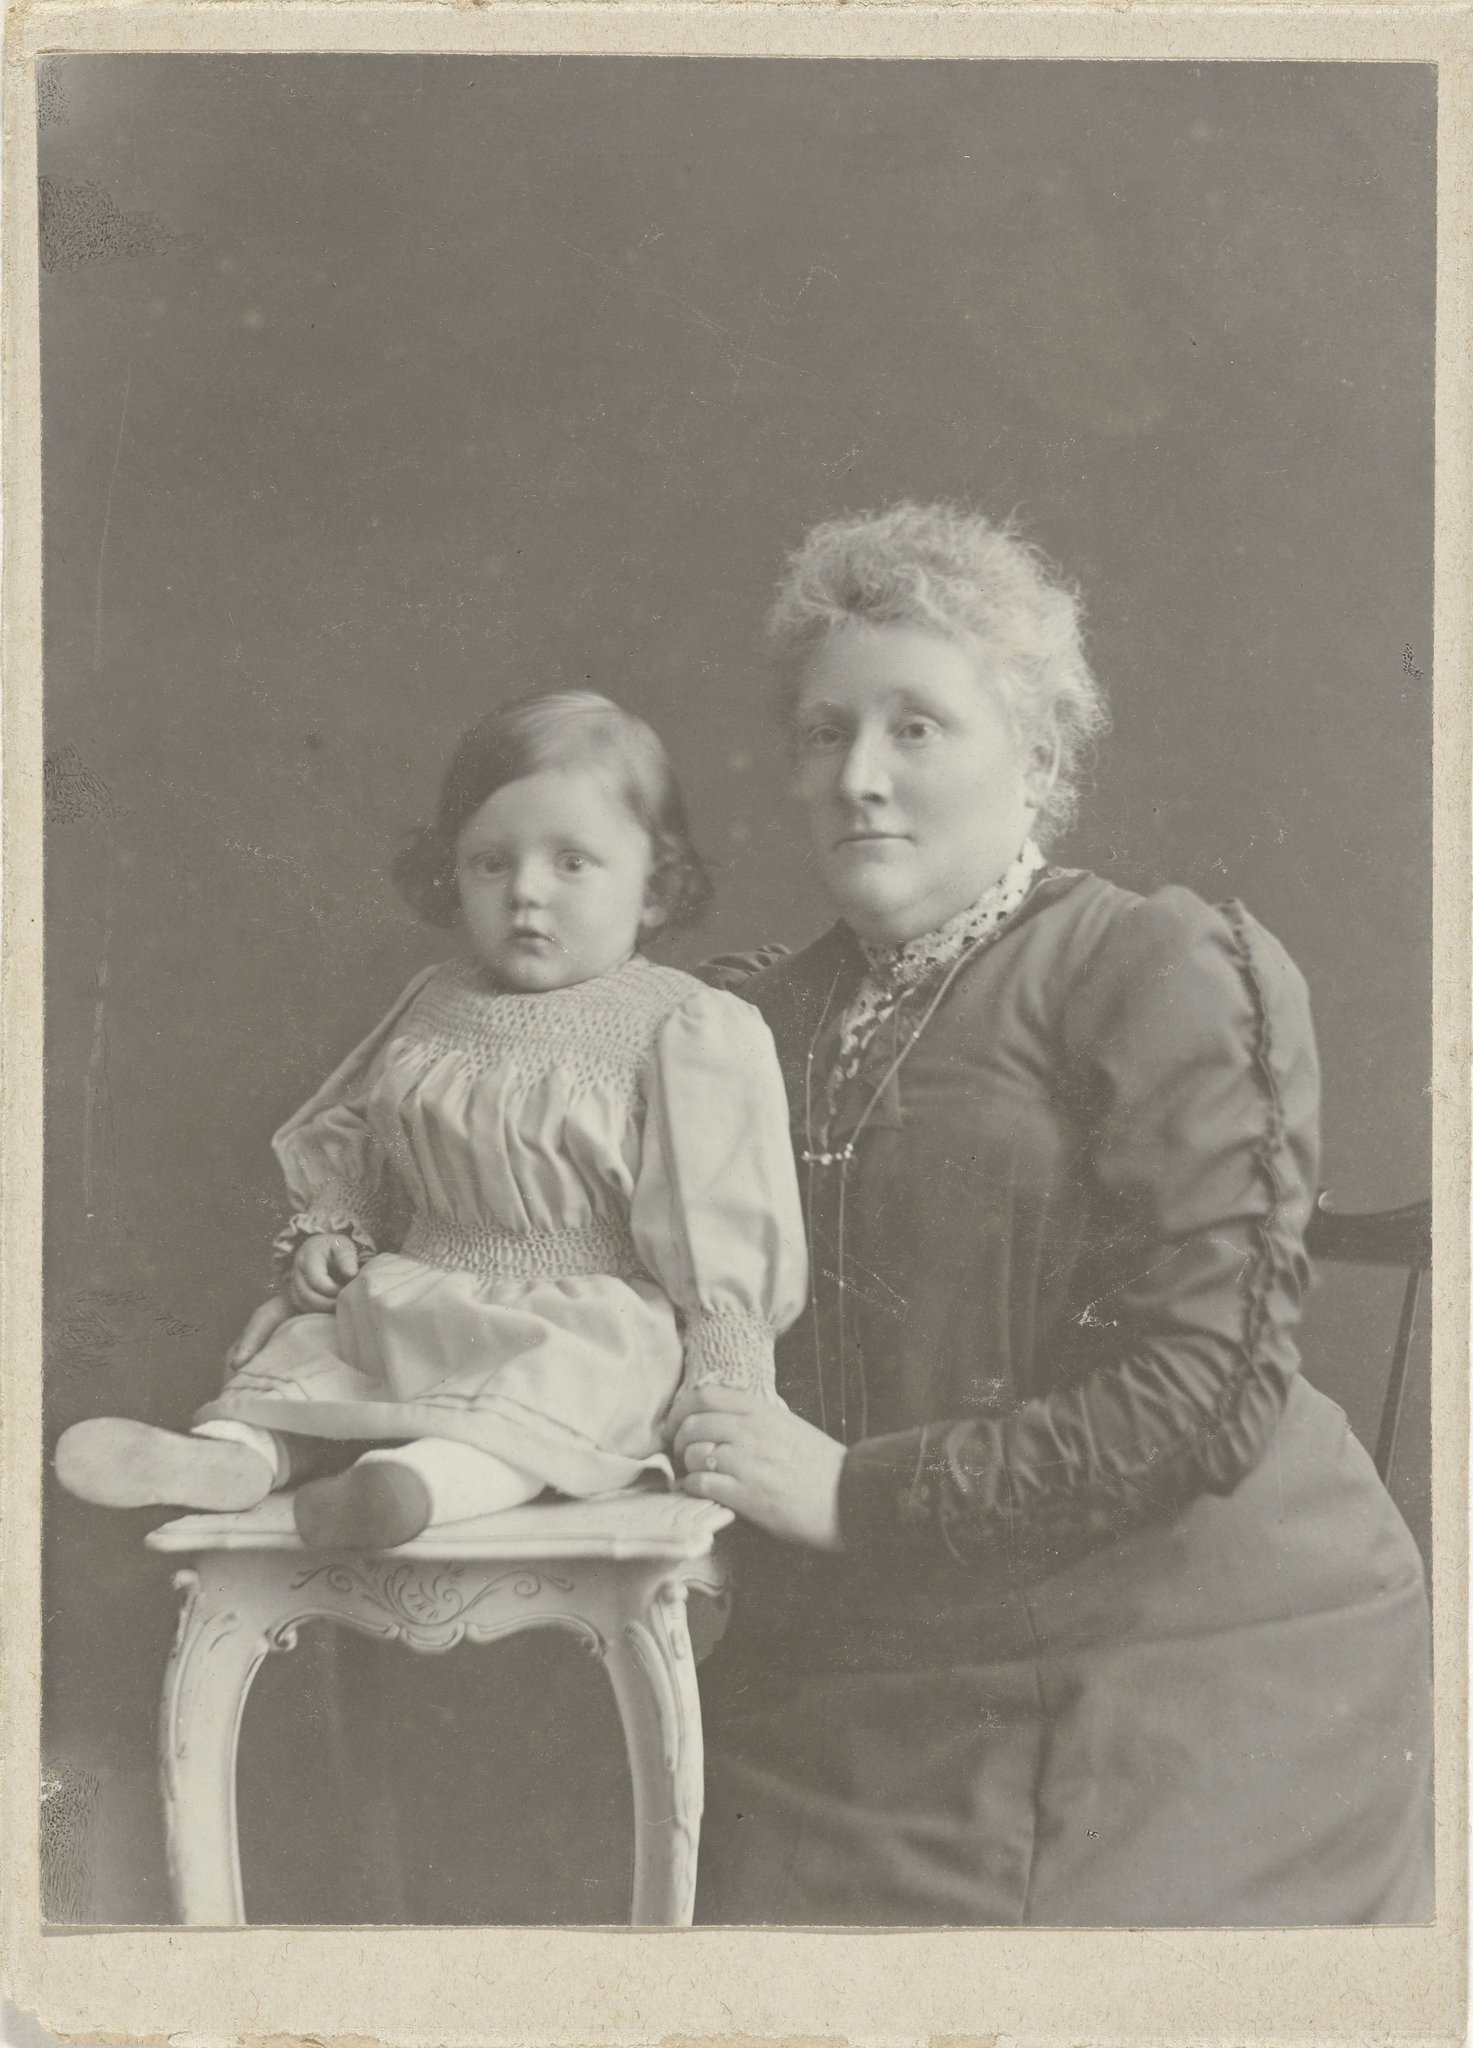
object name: cabinet photograph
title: Studioportret van moeder met dochter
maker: Anonymous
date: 1880-1920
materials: cardboard, photographic support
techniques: gelatin silver print